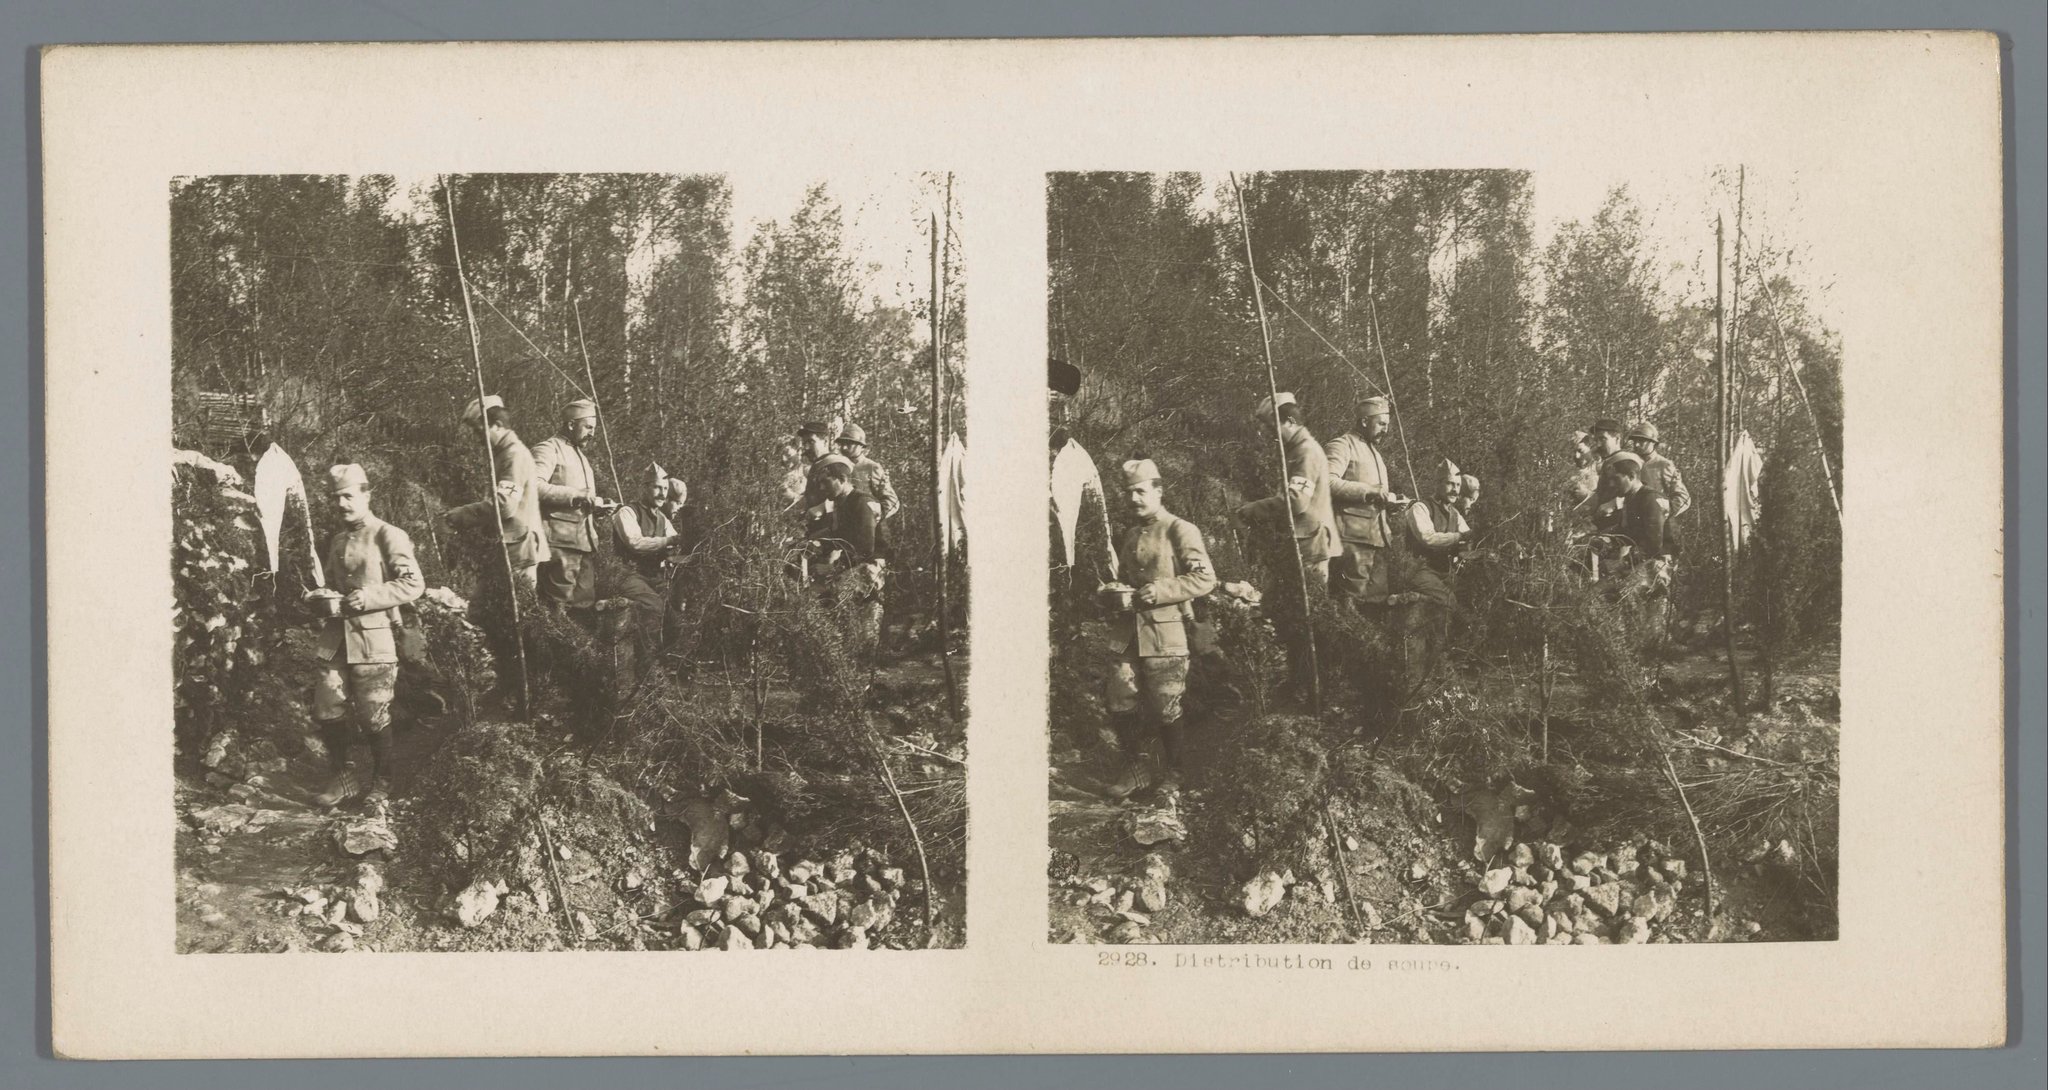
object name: stereograph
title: Distribution de soupe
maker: Anonymous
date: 1914-1918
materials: cardboard, photographic support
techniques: gelatin silver print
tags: soup-kitchen, cook-shop, serving of food ~ military service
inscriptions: number: ‘2928.’